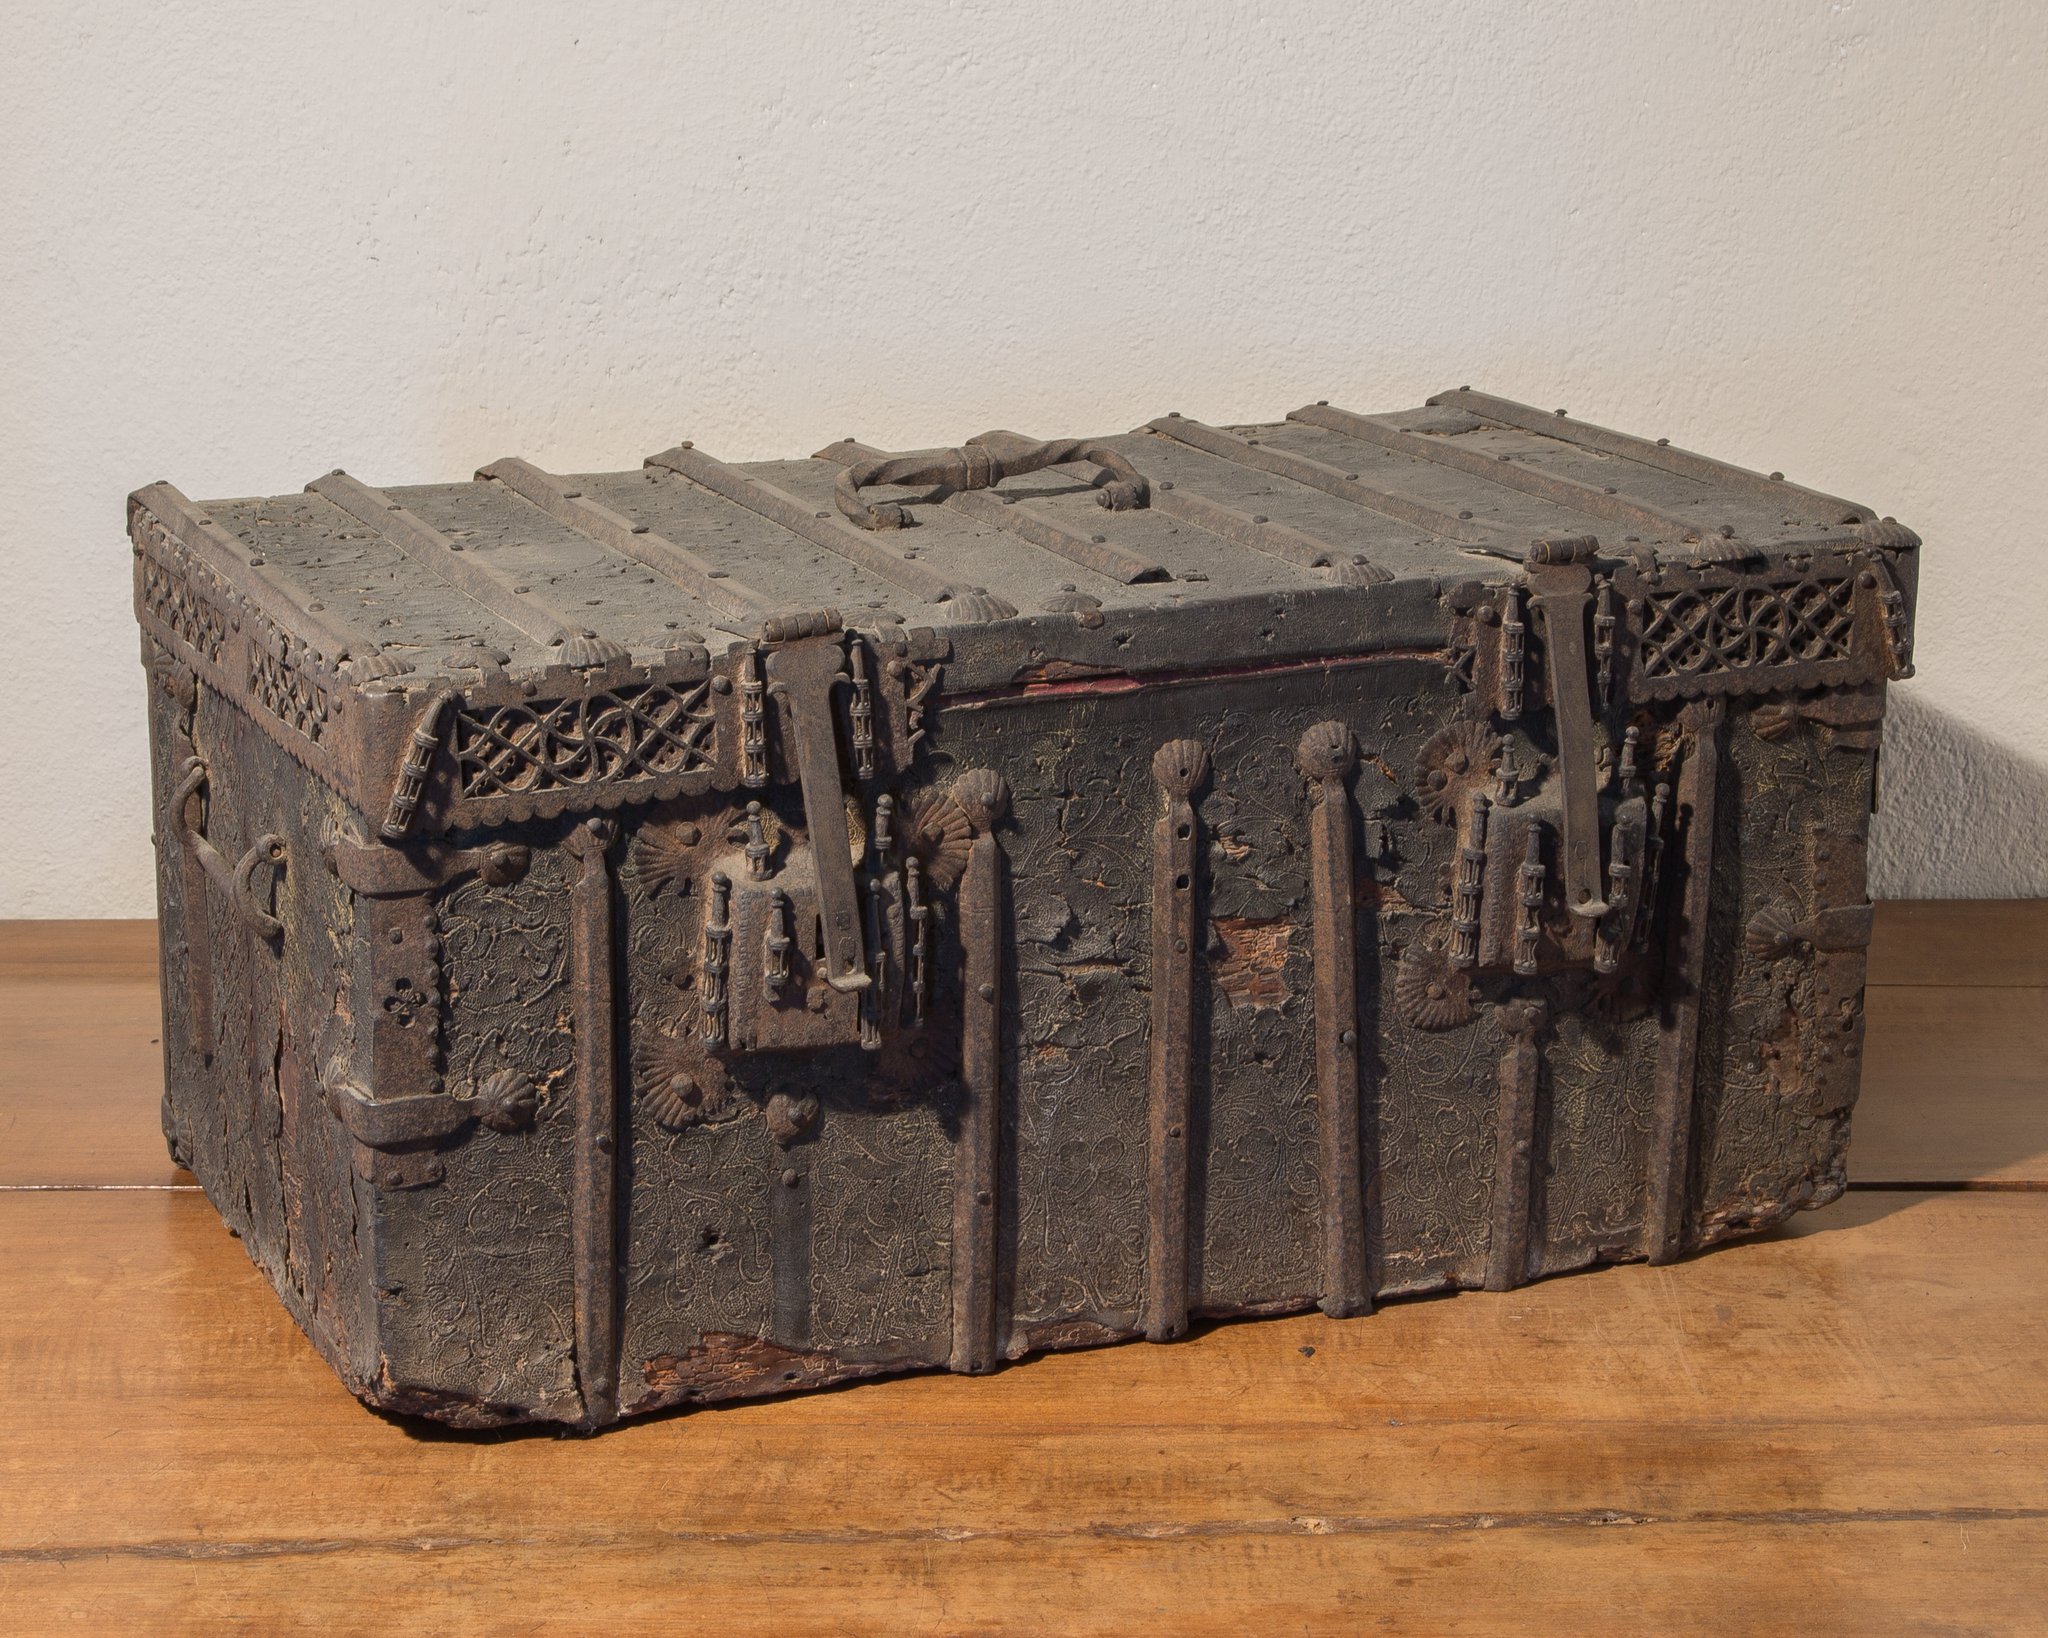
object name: coffer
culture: spanish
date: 1401-1500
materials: iron, leather, wood